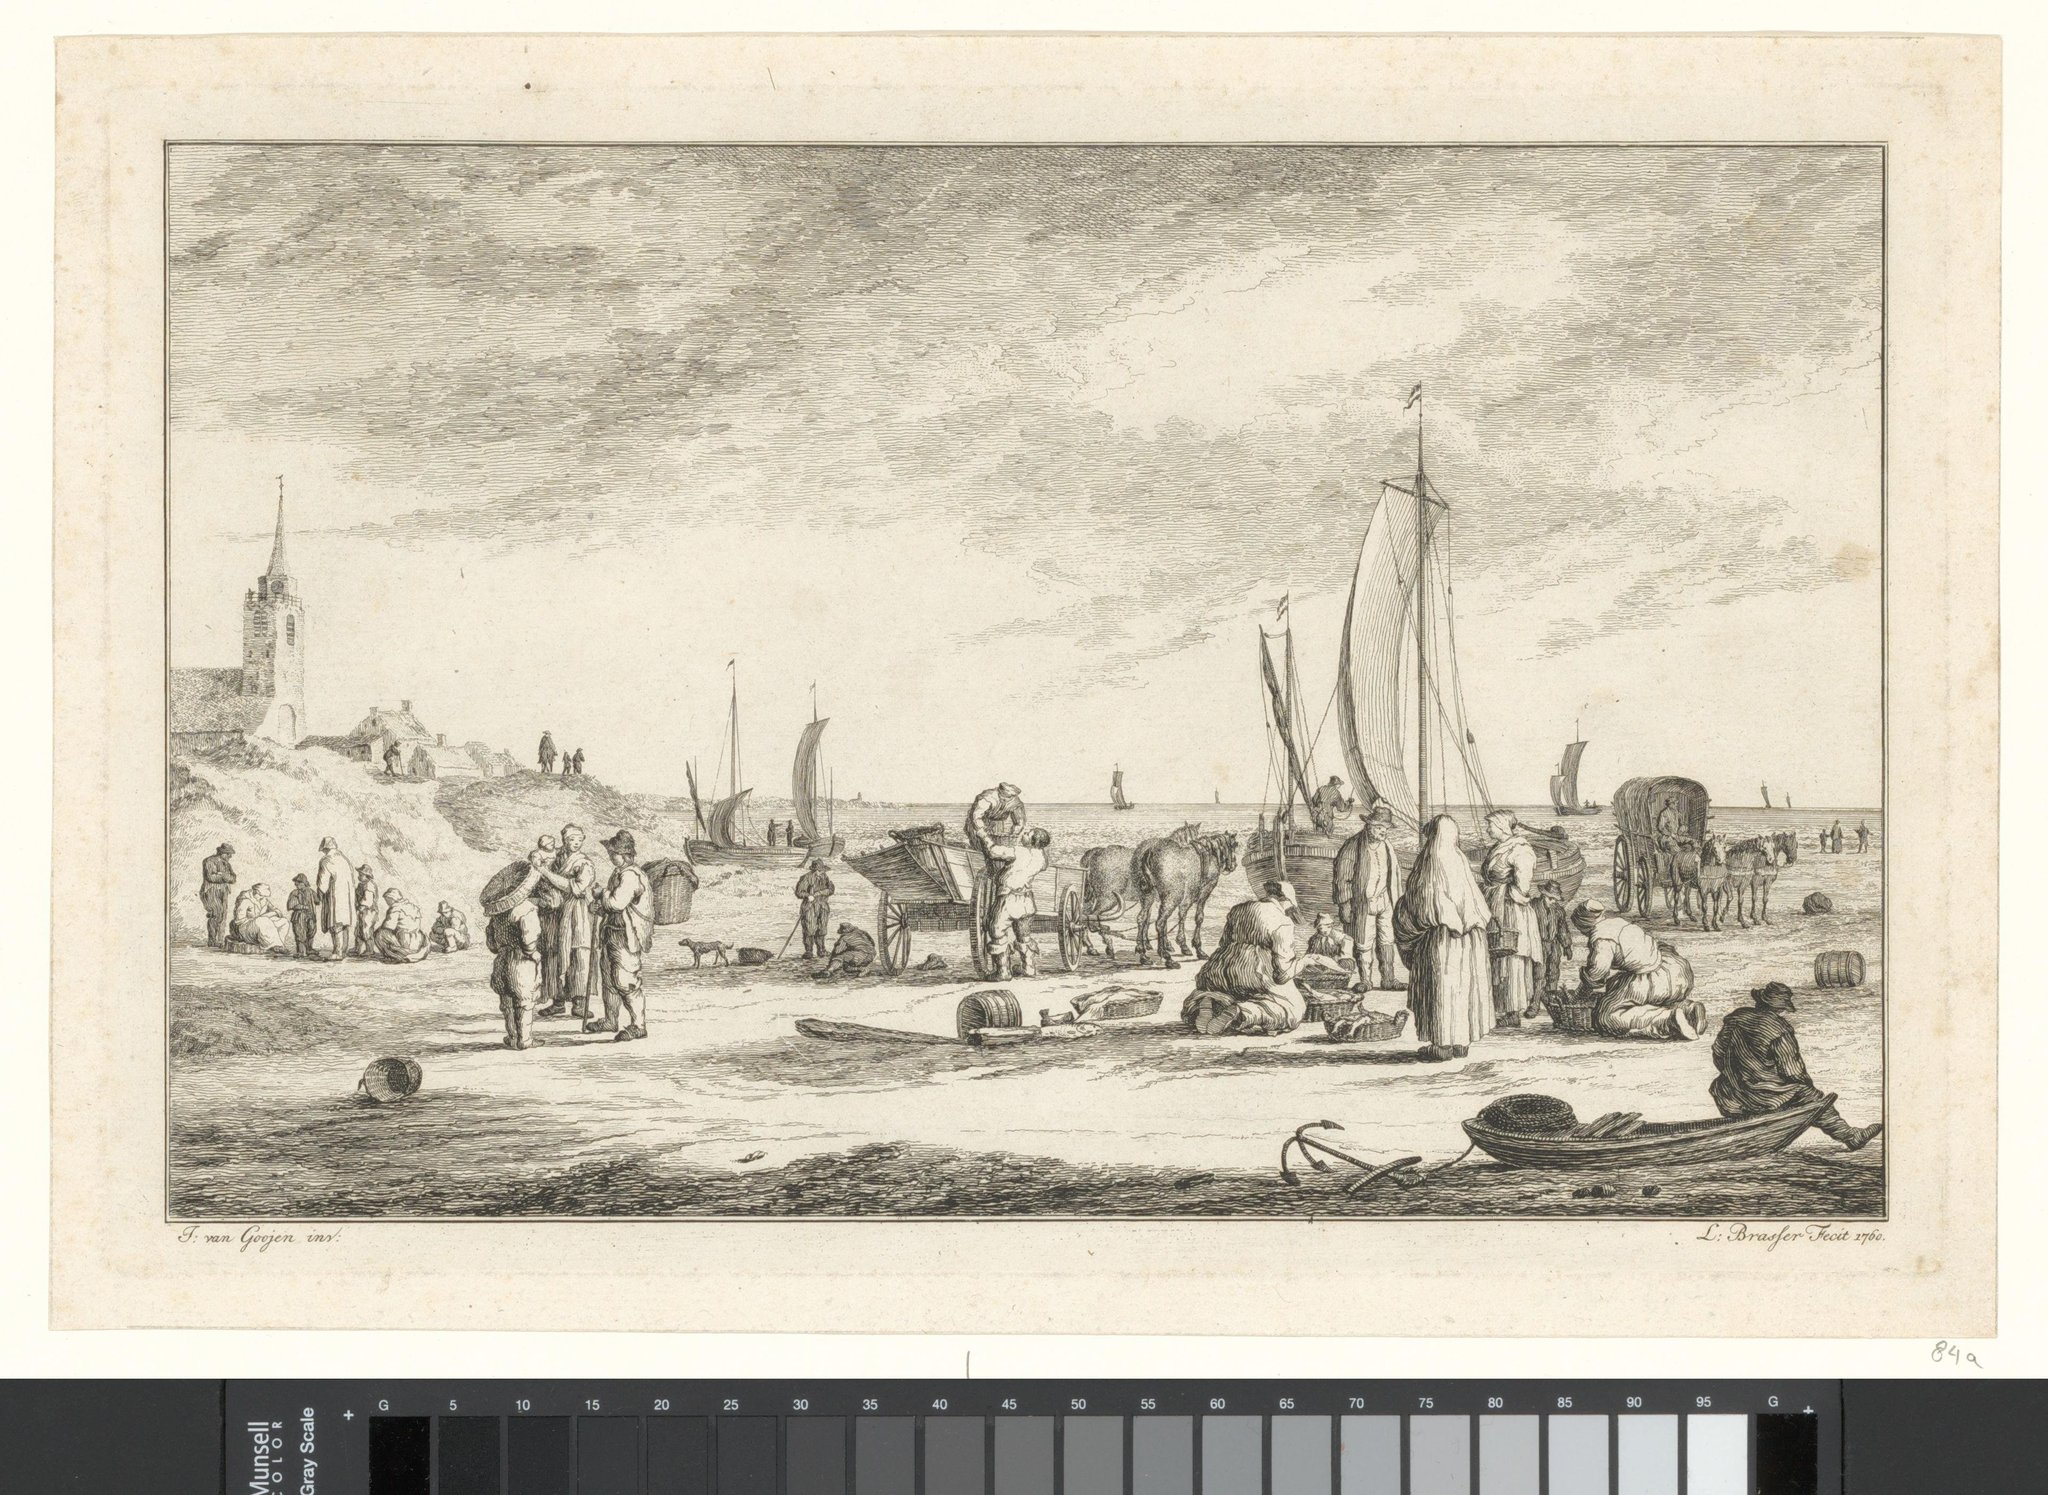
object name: print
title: Vissers en vissersboten op het strand bij Scheveningen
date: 1760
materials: paper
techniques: etching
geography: netherlands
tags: sailing-ship, sailing-boat, church (exterior), beach, fisherman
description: Gezicht op het strand met vissersboten, twee karren en vissers, vrouwen in de weer met manden en tonnen. Links het kerkje van Scheveningen. Op de achtergrond de zee met vissersschepen. Onderwerpsrubrieken binnen de Atlas Zeden en Gewoonten: Beroep en bedrijf. Vrouwelijk beroep en bedrijf. Eet- en drinkwaren.